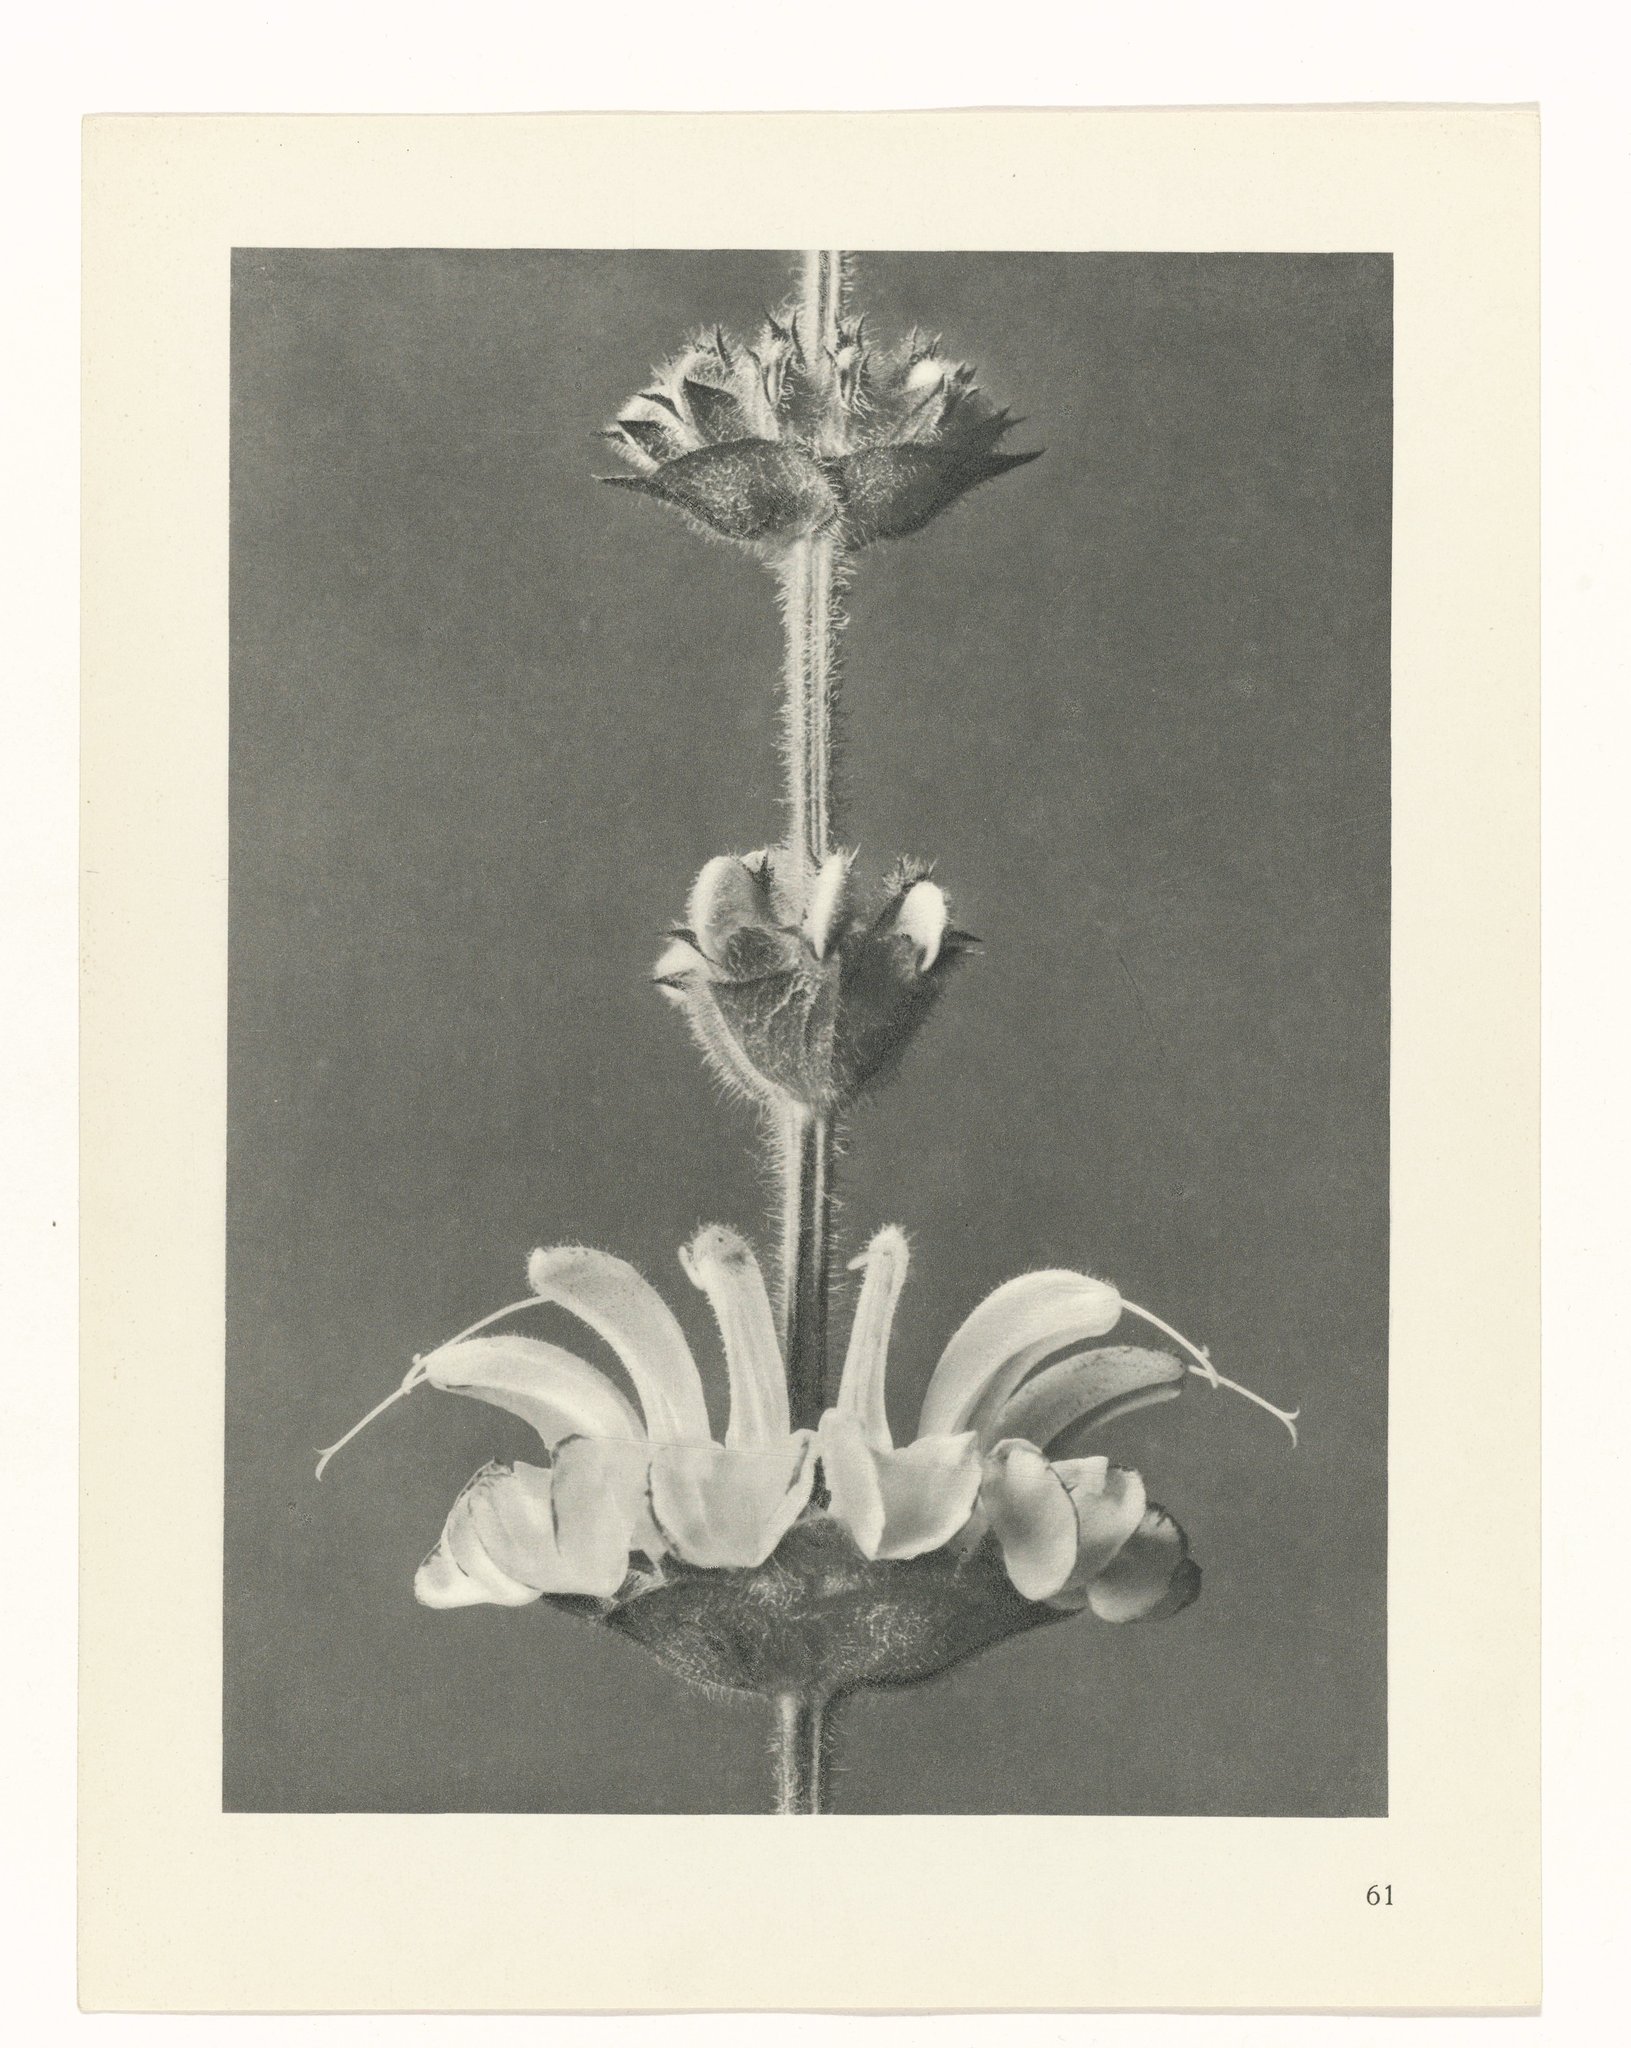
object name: photograph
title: Urformen der Kunst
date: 1928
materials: ink, paper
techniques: rotogravure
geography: berlin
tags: plants (in general)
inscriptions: number: ‘61’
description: facher Vergrößerung. Afkomstig uit losbladige uitgave.